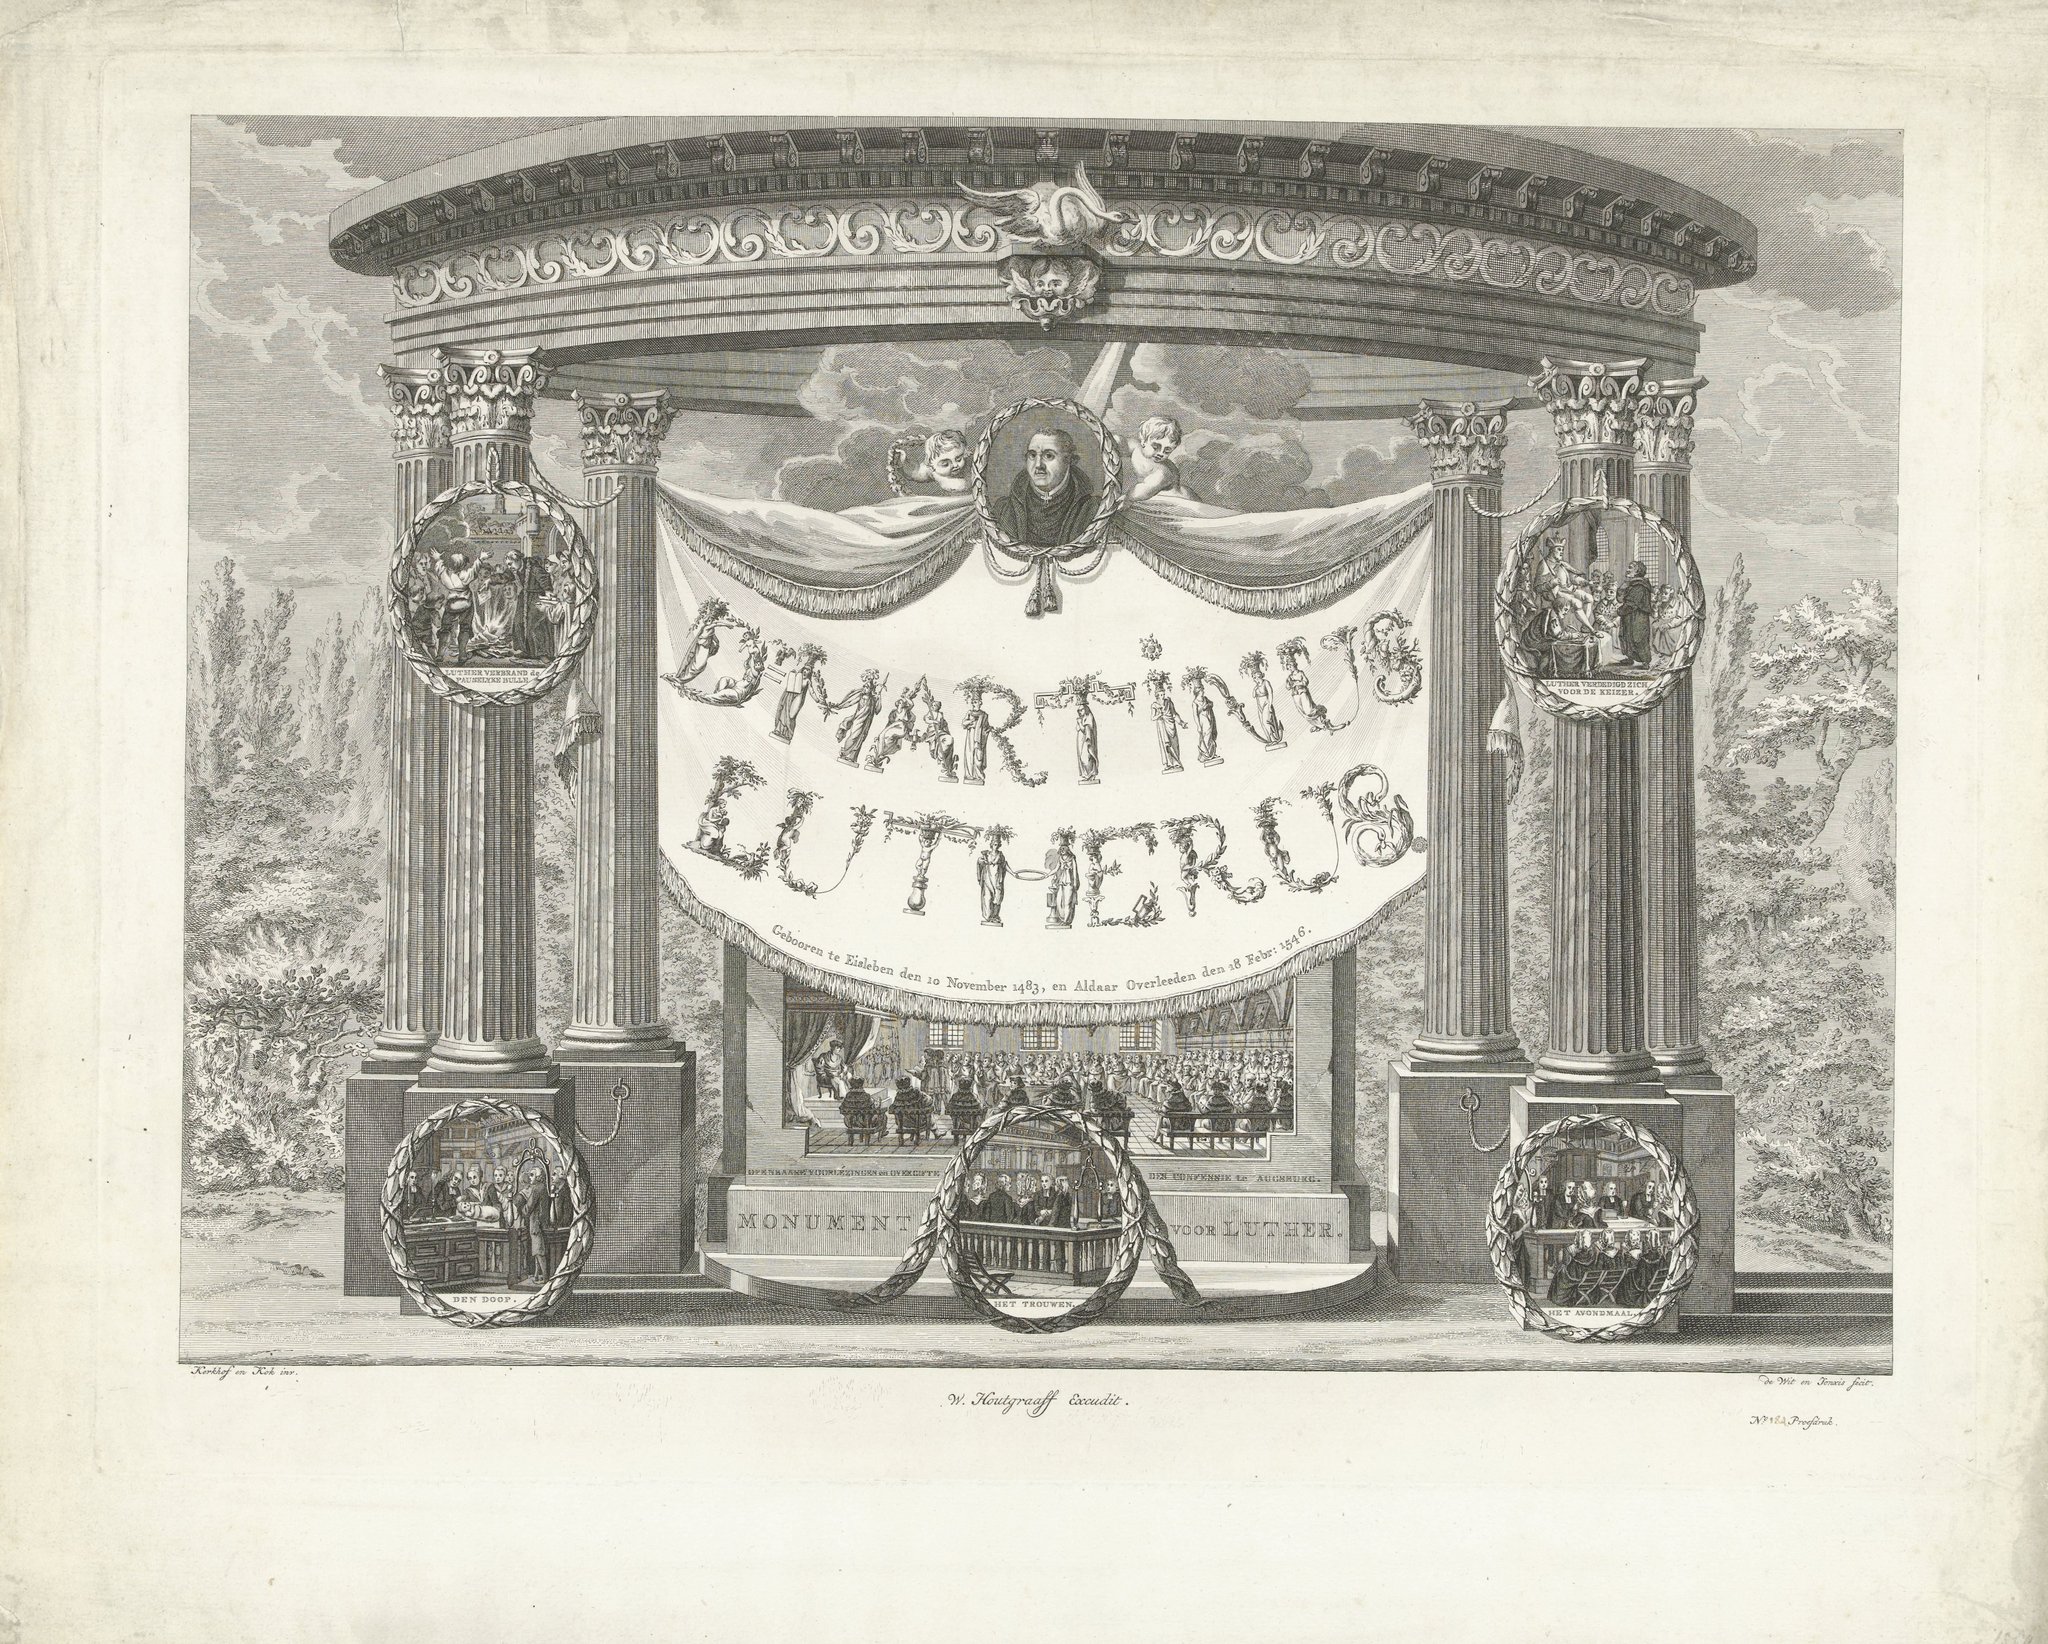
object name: print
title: Monument ter nagedachtenis aan Maarten Luther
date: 1772-1843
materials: paper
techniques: engraving, etching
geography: northern netherlands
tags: priest, martin luther, water-birds: swan, other memorial structures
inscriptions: collector's mark: Lugt 2228, number: ‘206’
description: Landschap met een monument, op de kroonlijst de Lutherse zwaan. Tussen de zuilen hangt het portret van Maarten Luther. Op een doek zijn naam in sierletters. Daaronder een voorstelling van de confessie te Augsburg. Medaillons waarin voorstellingen uit het leven van Luther zijn aan het monument bevestigd.